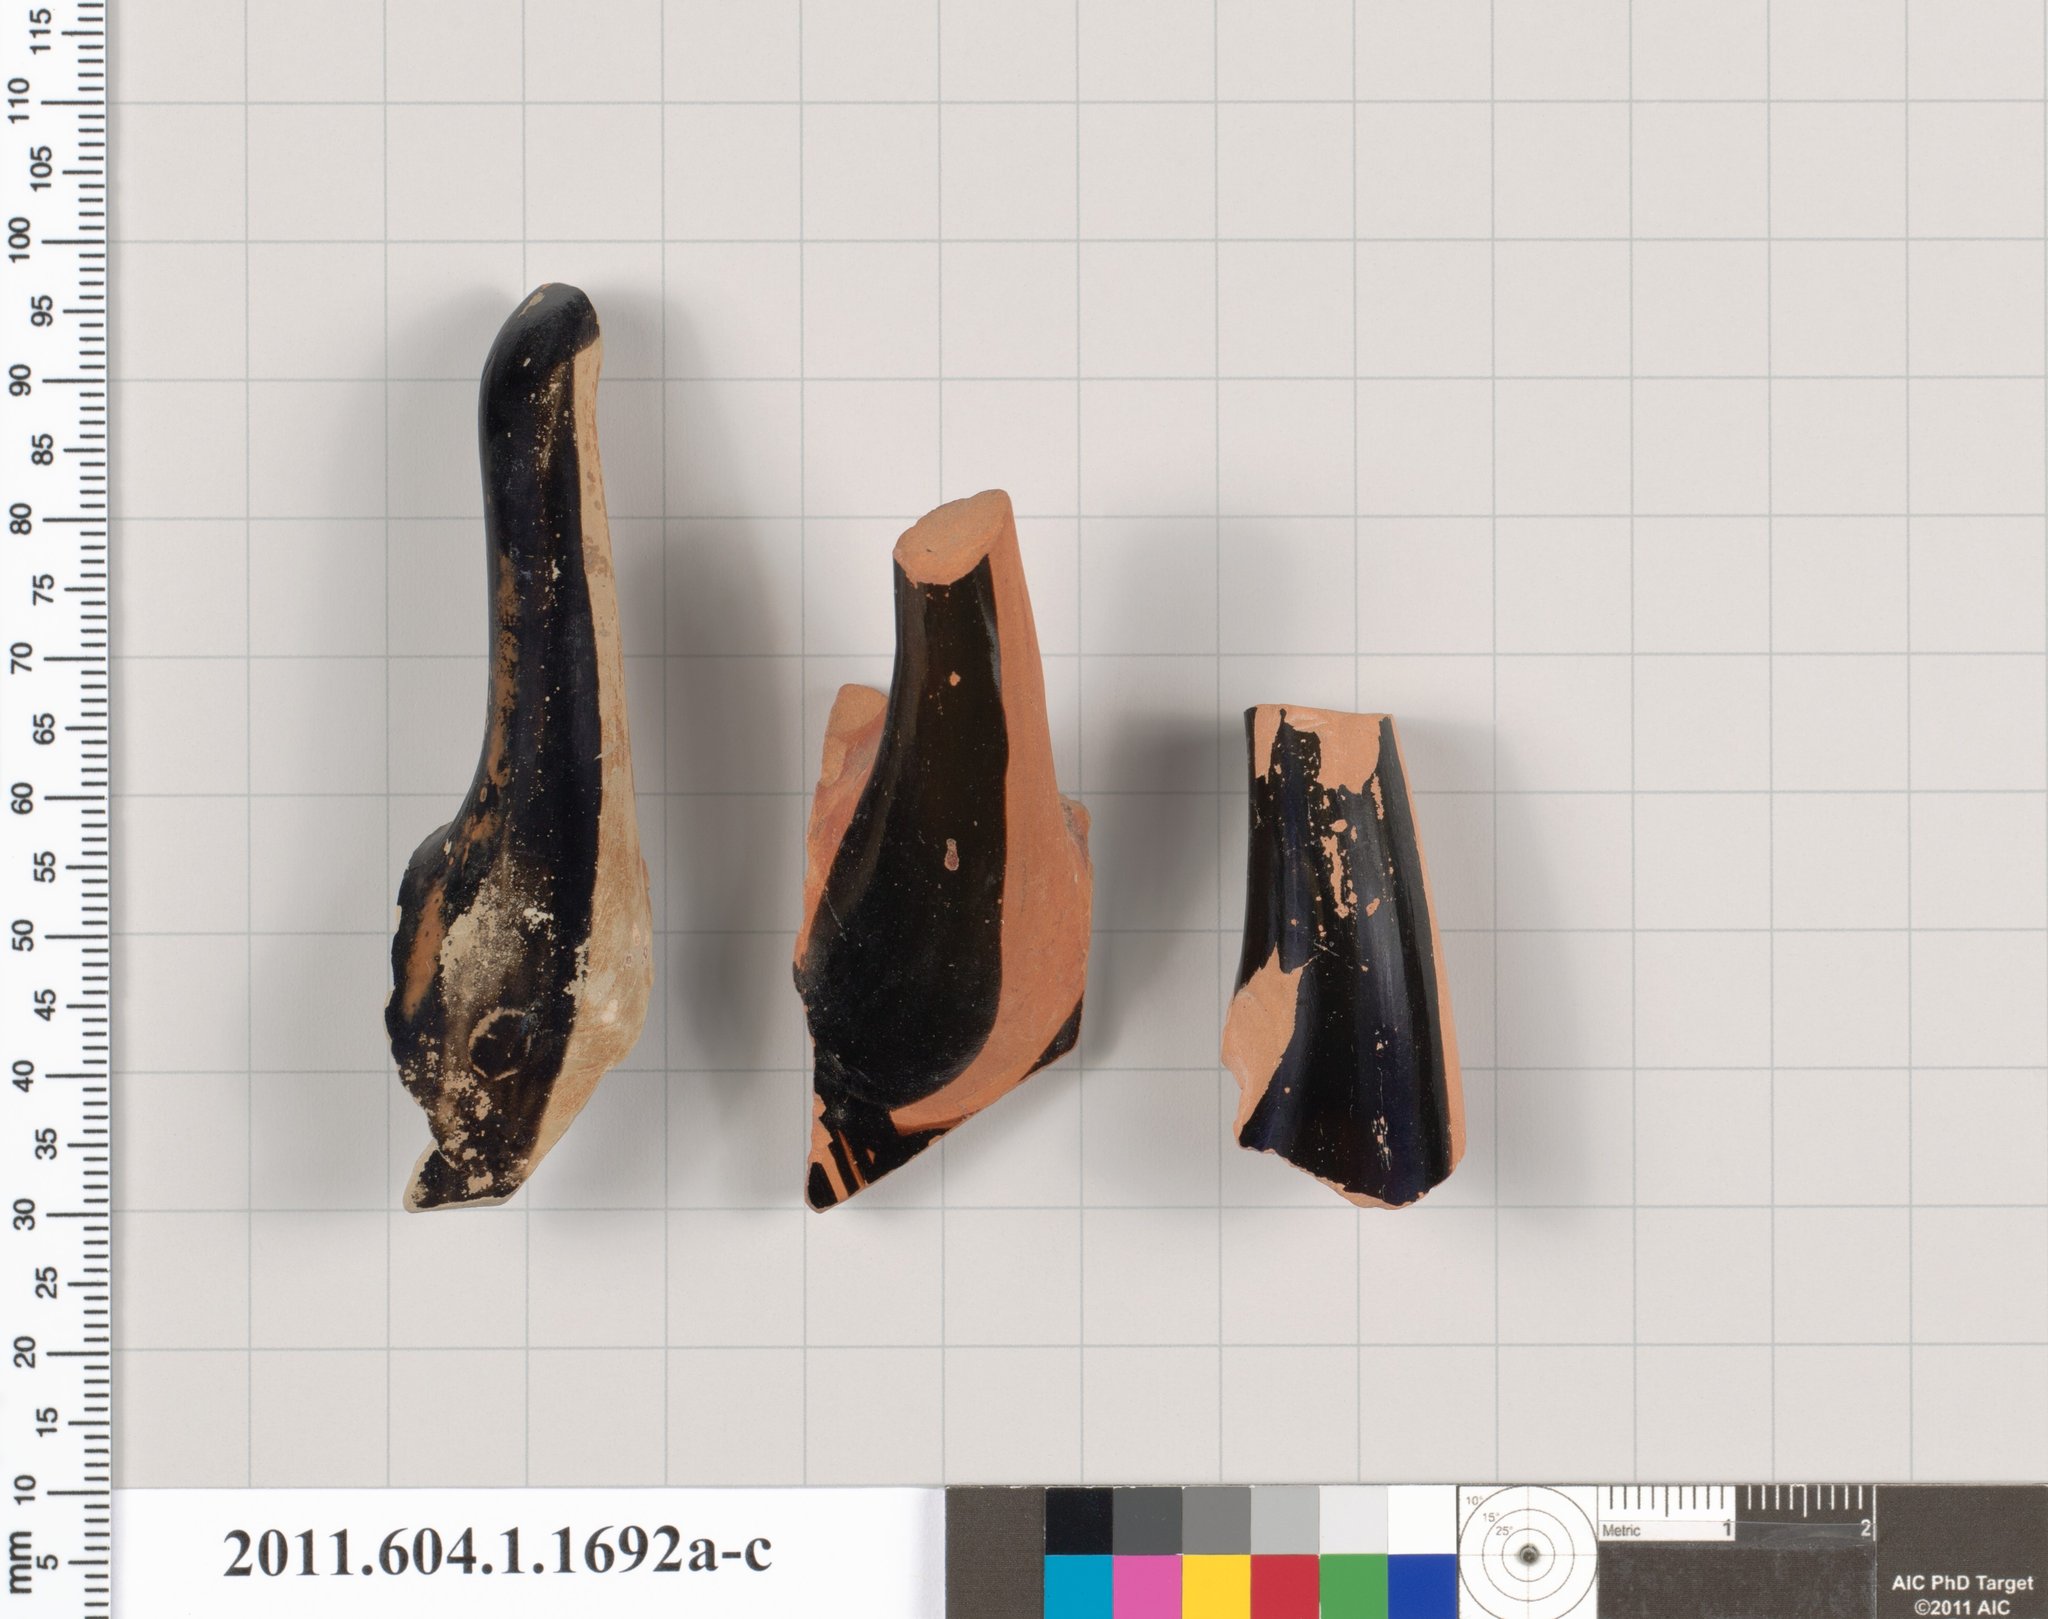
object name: kylix fragment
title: Terracotta fragments of kylikes (drinking cups)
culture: greek, attic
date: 500-401 BCE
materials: terracotta